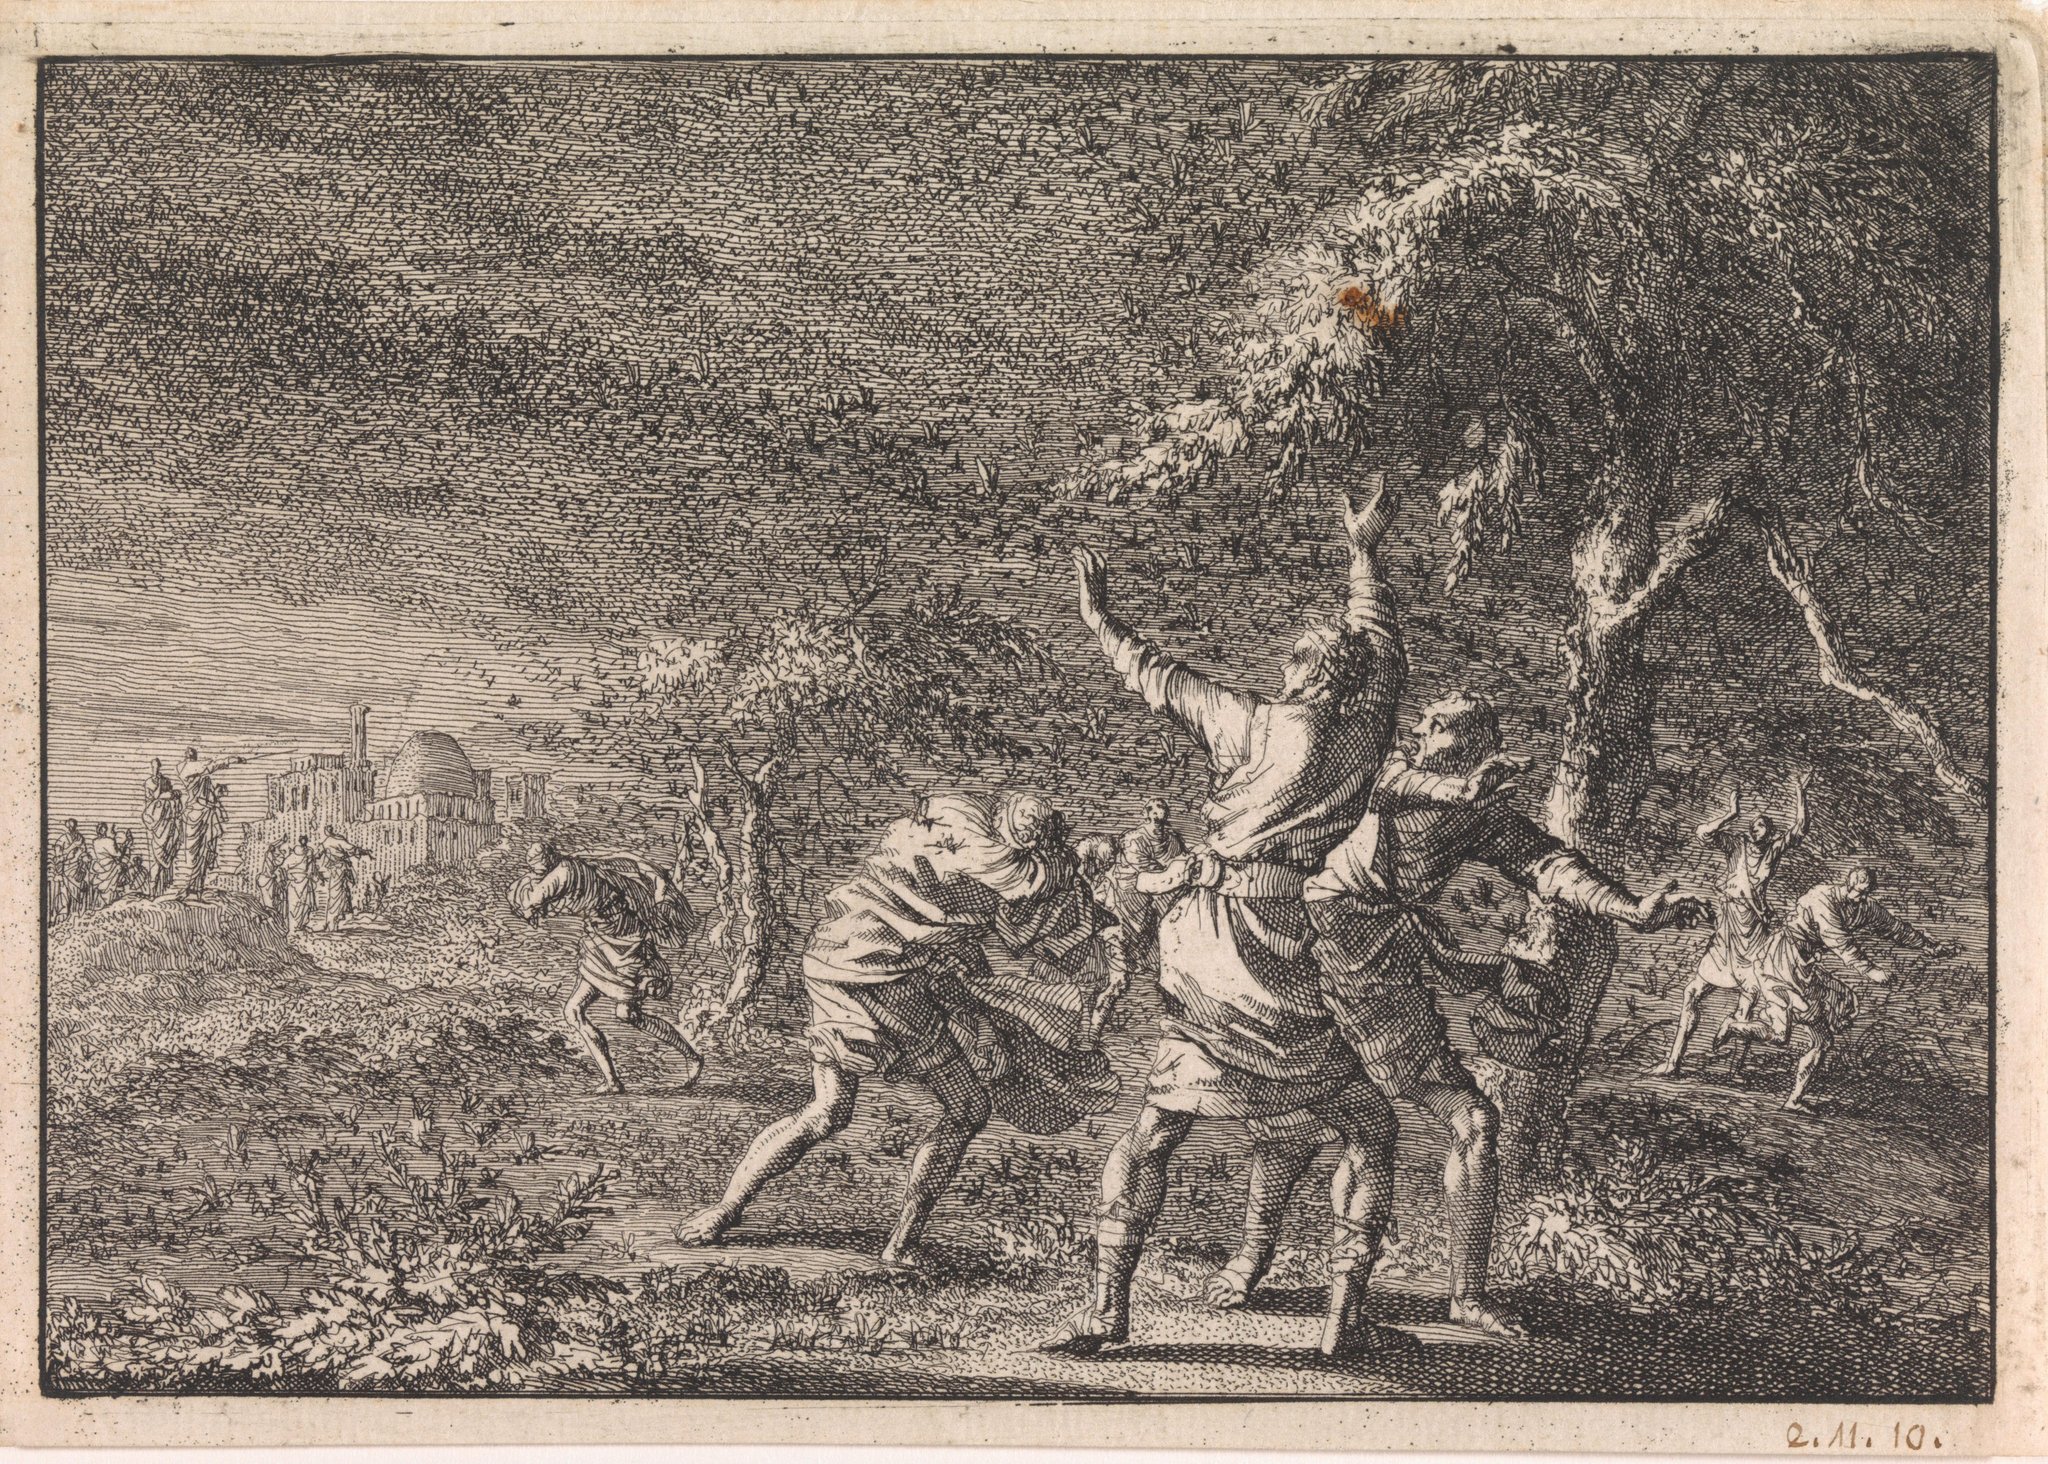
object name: print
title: Plaag van de sprinkhanen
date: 1703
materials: paper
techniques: etching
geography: haarlem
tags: the plague of locusts: as moses raises his hands the locusts come and eat everything that has survived the hail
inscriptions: collector's mark: Lugt 2228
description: Proefdruk van een boekillustratie voor David Martin. Historie des Ouden en Nieuwen Testaments. Amsterdam, Pieter Mortier, 1703. Deel I. De boekillustraties voor de Mortierbijbel hebben verschillende staten en kopieën, waarbij de chronologische volgorde moeilijk te achterhalen valt. Als boekillustraties werden ze bovendien herhaaldelijk opnieuw gebruikt voor andere boekwerken.